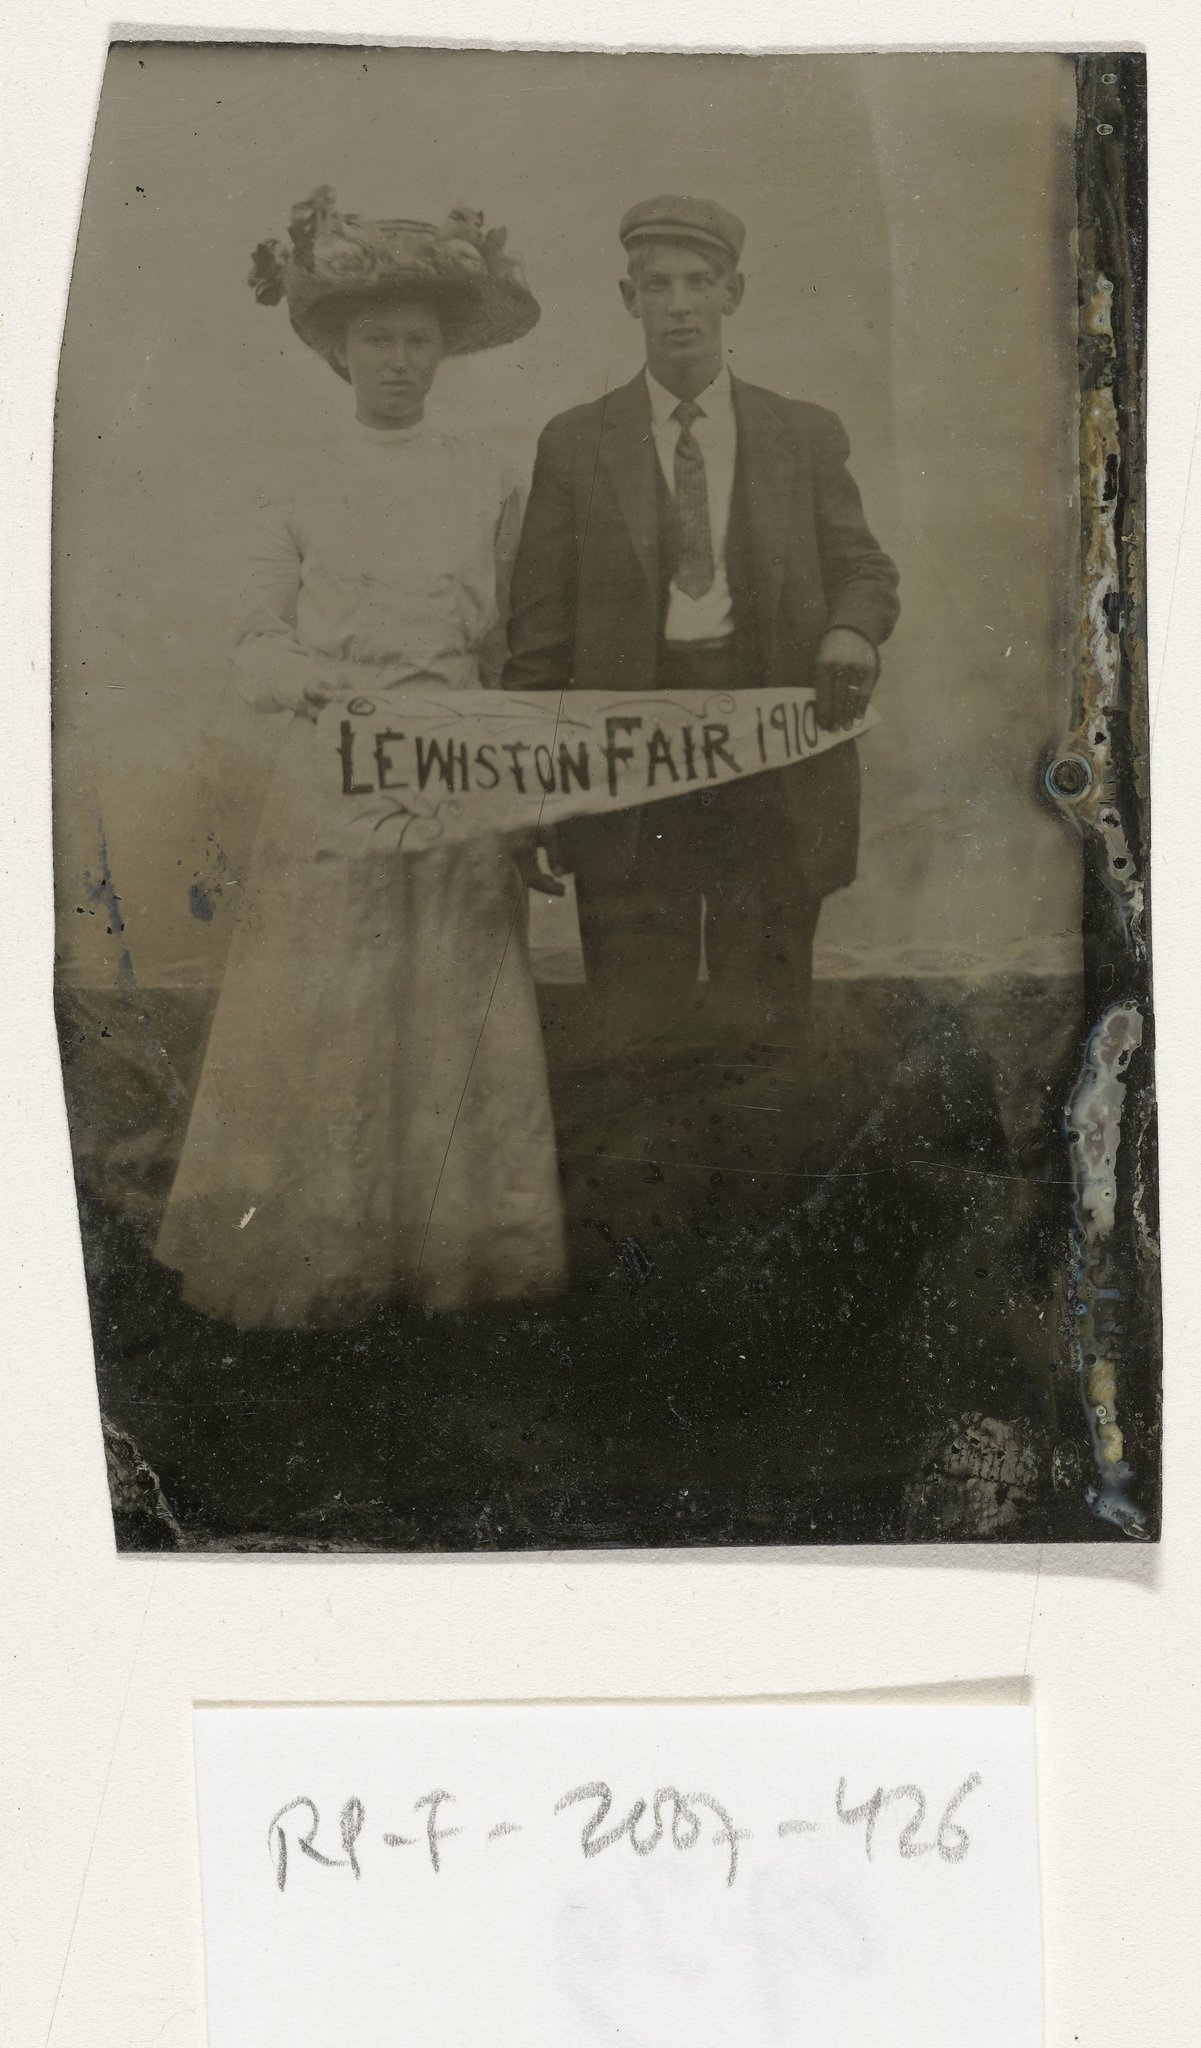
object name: photograph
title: Portrait of a man and a woman holding a sign with the text LEWISTON FAIR 1910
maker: Anonymous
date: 1910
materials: metal, paper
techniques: ferrotyping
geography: united states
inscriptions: date